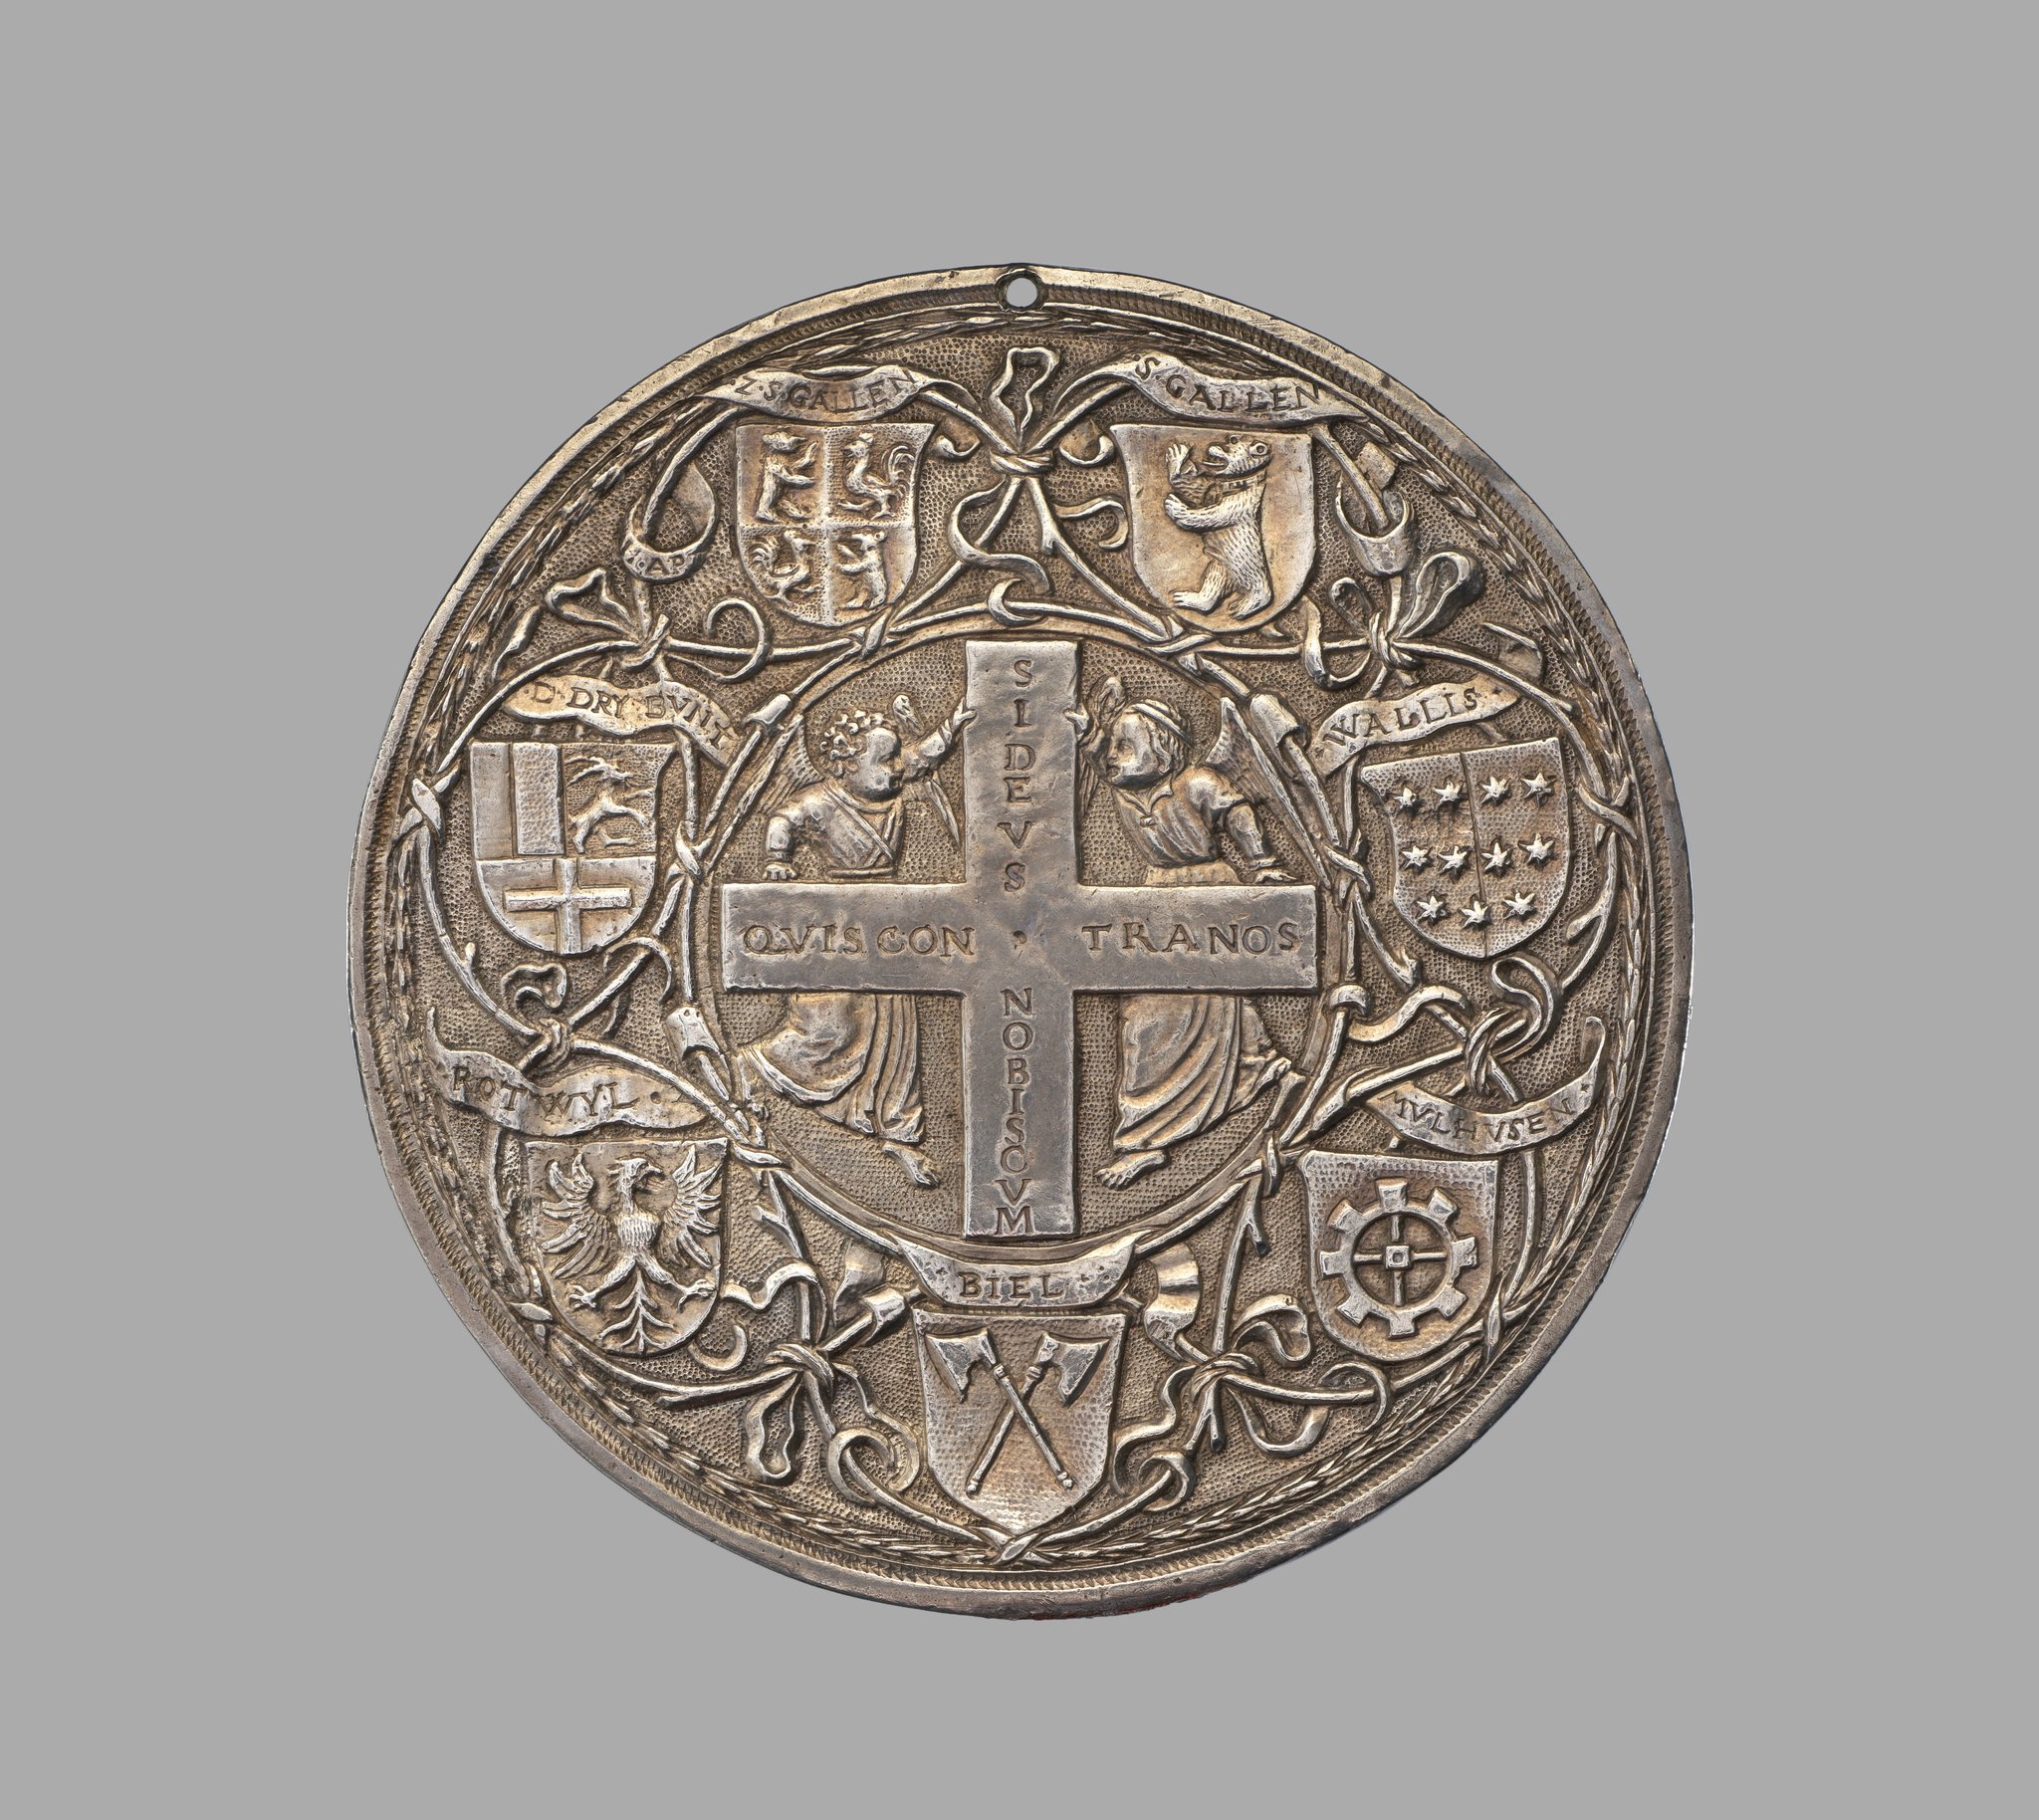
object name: medal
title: Medal Issued by the Swiss Cantons on the Birth of Princess Claude of France (1547–1575)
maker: hans jacob stampfer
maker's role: maker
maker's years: 1505-1579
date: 1547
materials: silver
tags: coat of arms